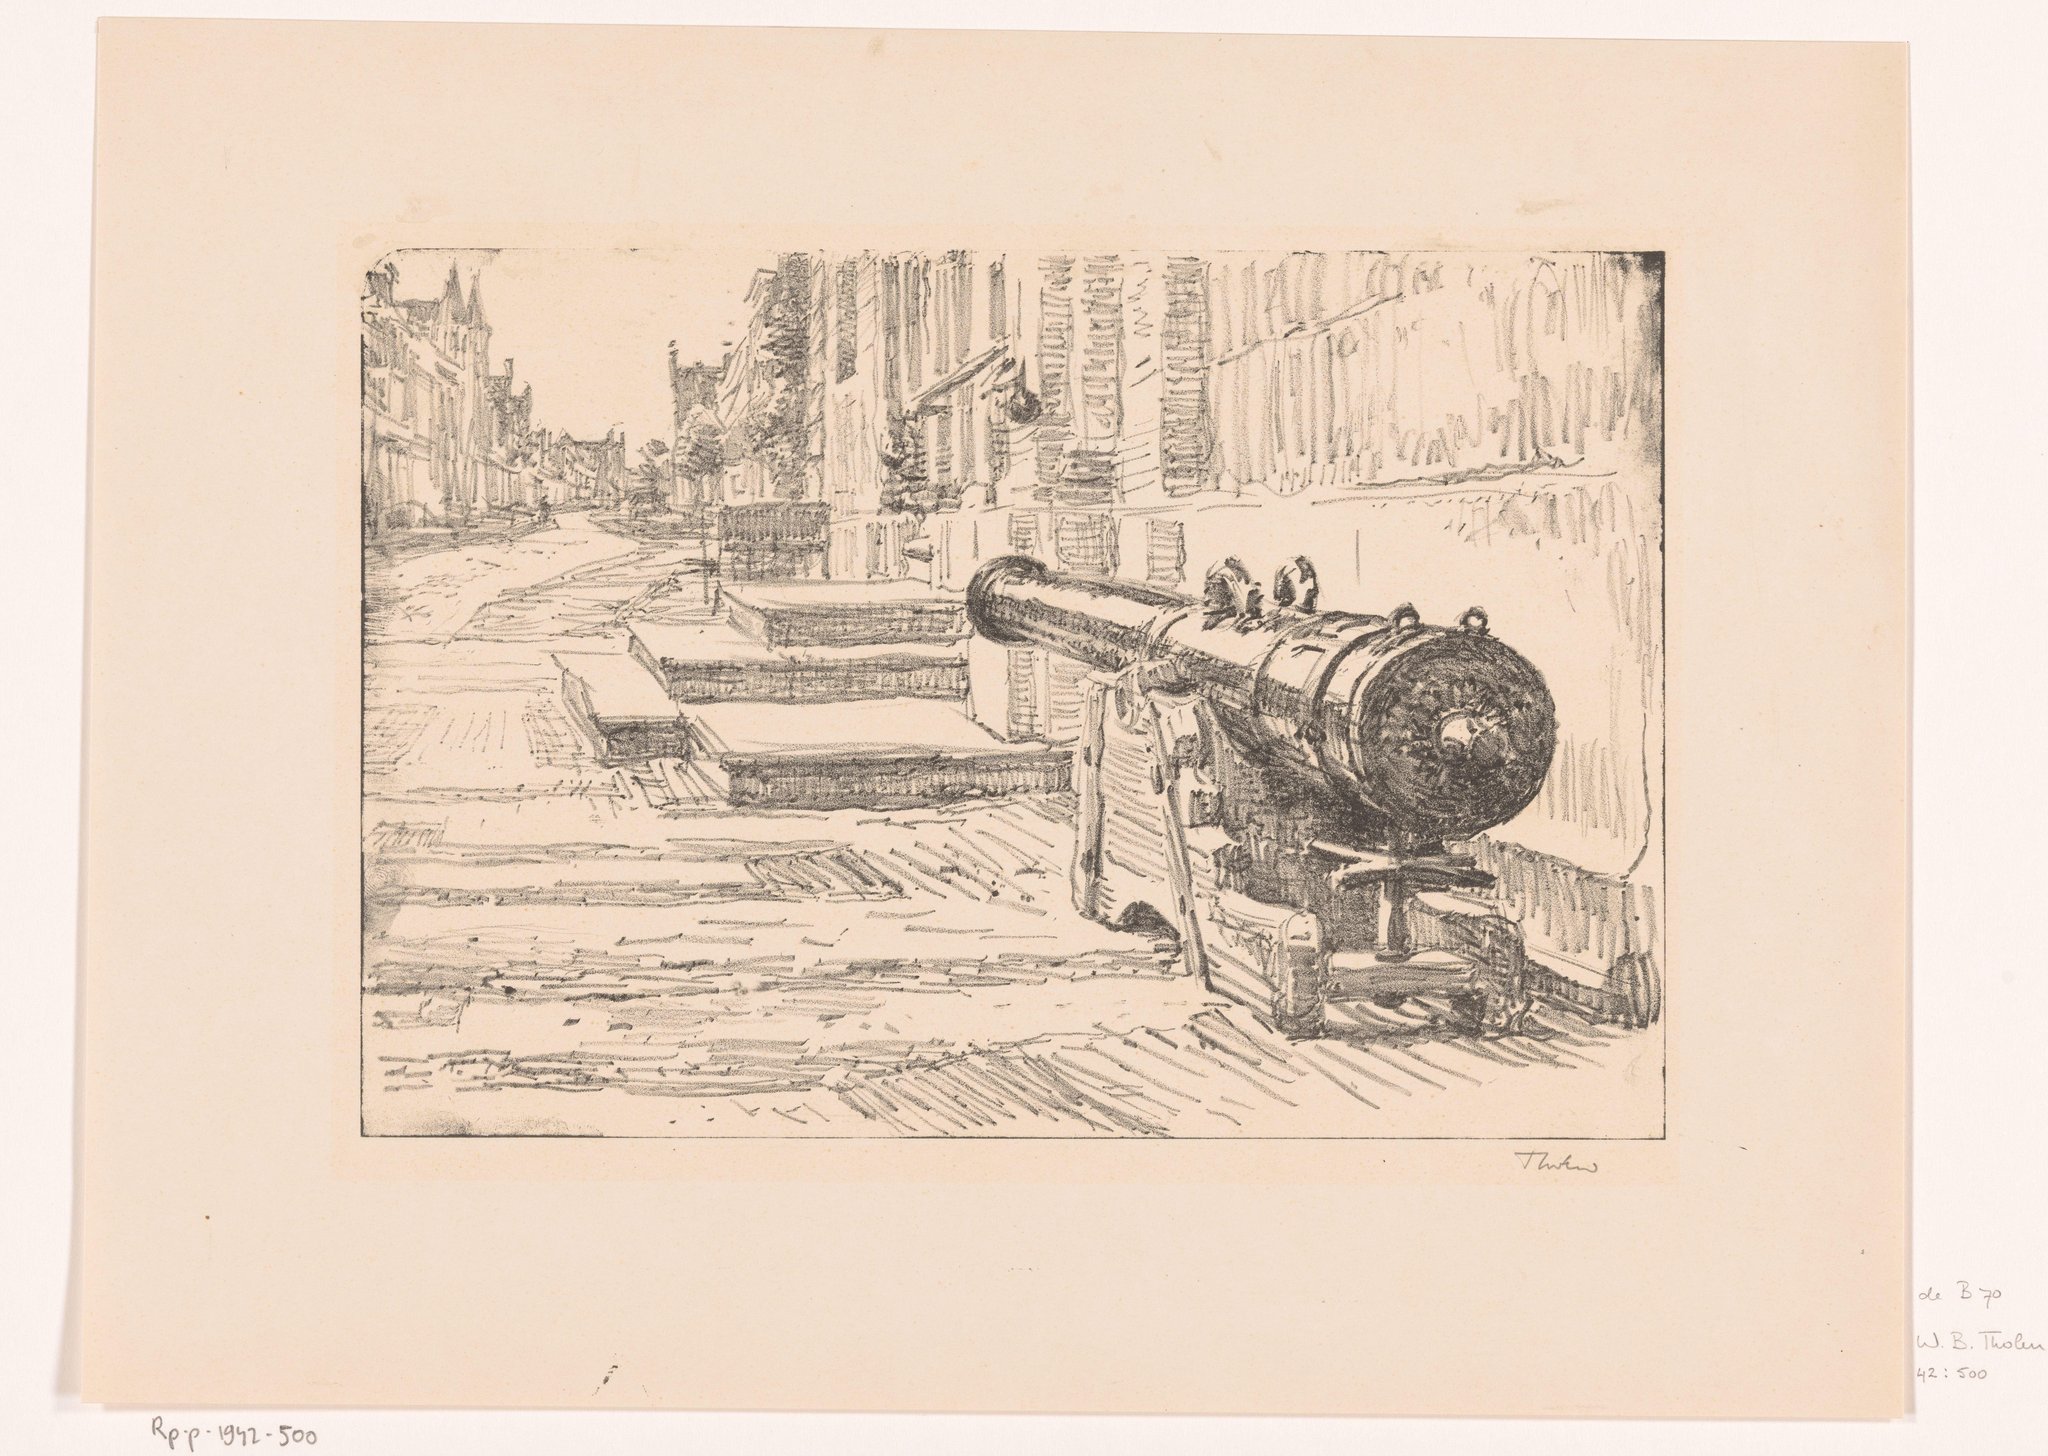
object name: print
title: Kanon in een straat in Enkhuizen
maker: willem bastiaan tholen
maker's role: draughtsman, painter, print maker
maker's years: 1860-1931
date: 1870-1931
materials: paper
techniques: lithograph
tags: firearms: cannon, street, enkhuizen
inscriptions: collector's mark: Lugt 2228